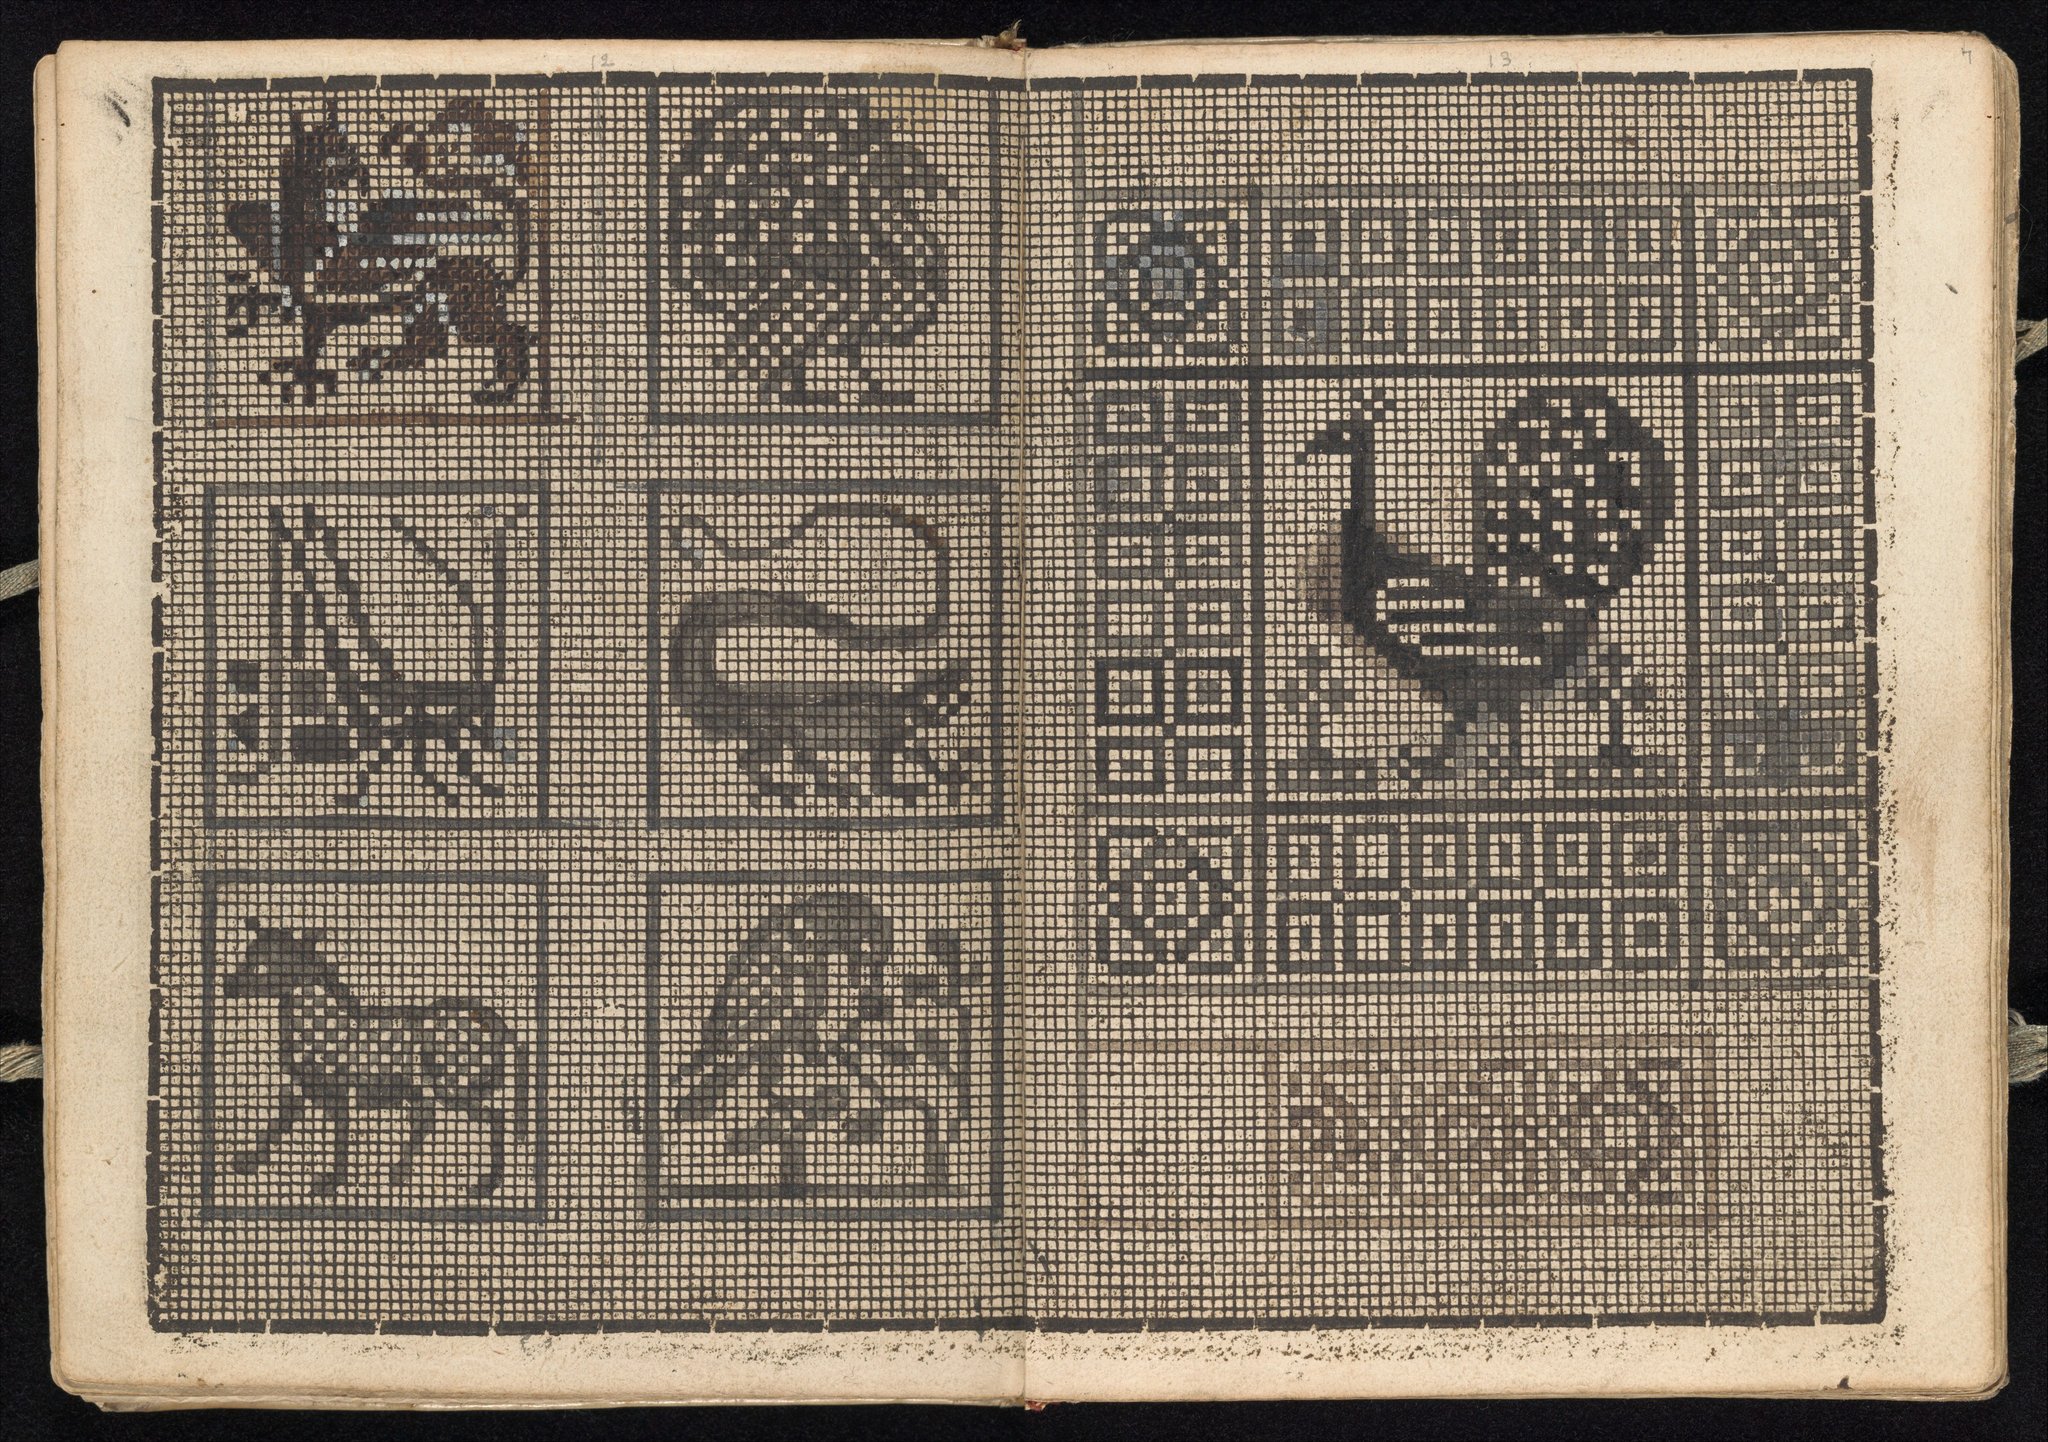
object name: book print ornament architecture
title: Manuscript album of designs for lace and embroidery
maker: anonymous, german, 16th century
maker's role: artist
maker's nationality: german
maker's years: 1500-1600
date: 1596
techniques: woodcut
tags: birds,griffins,peacocks,lizards